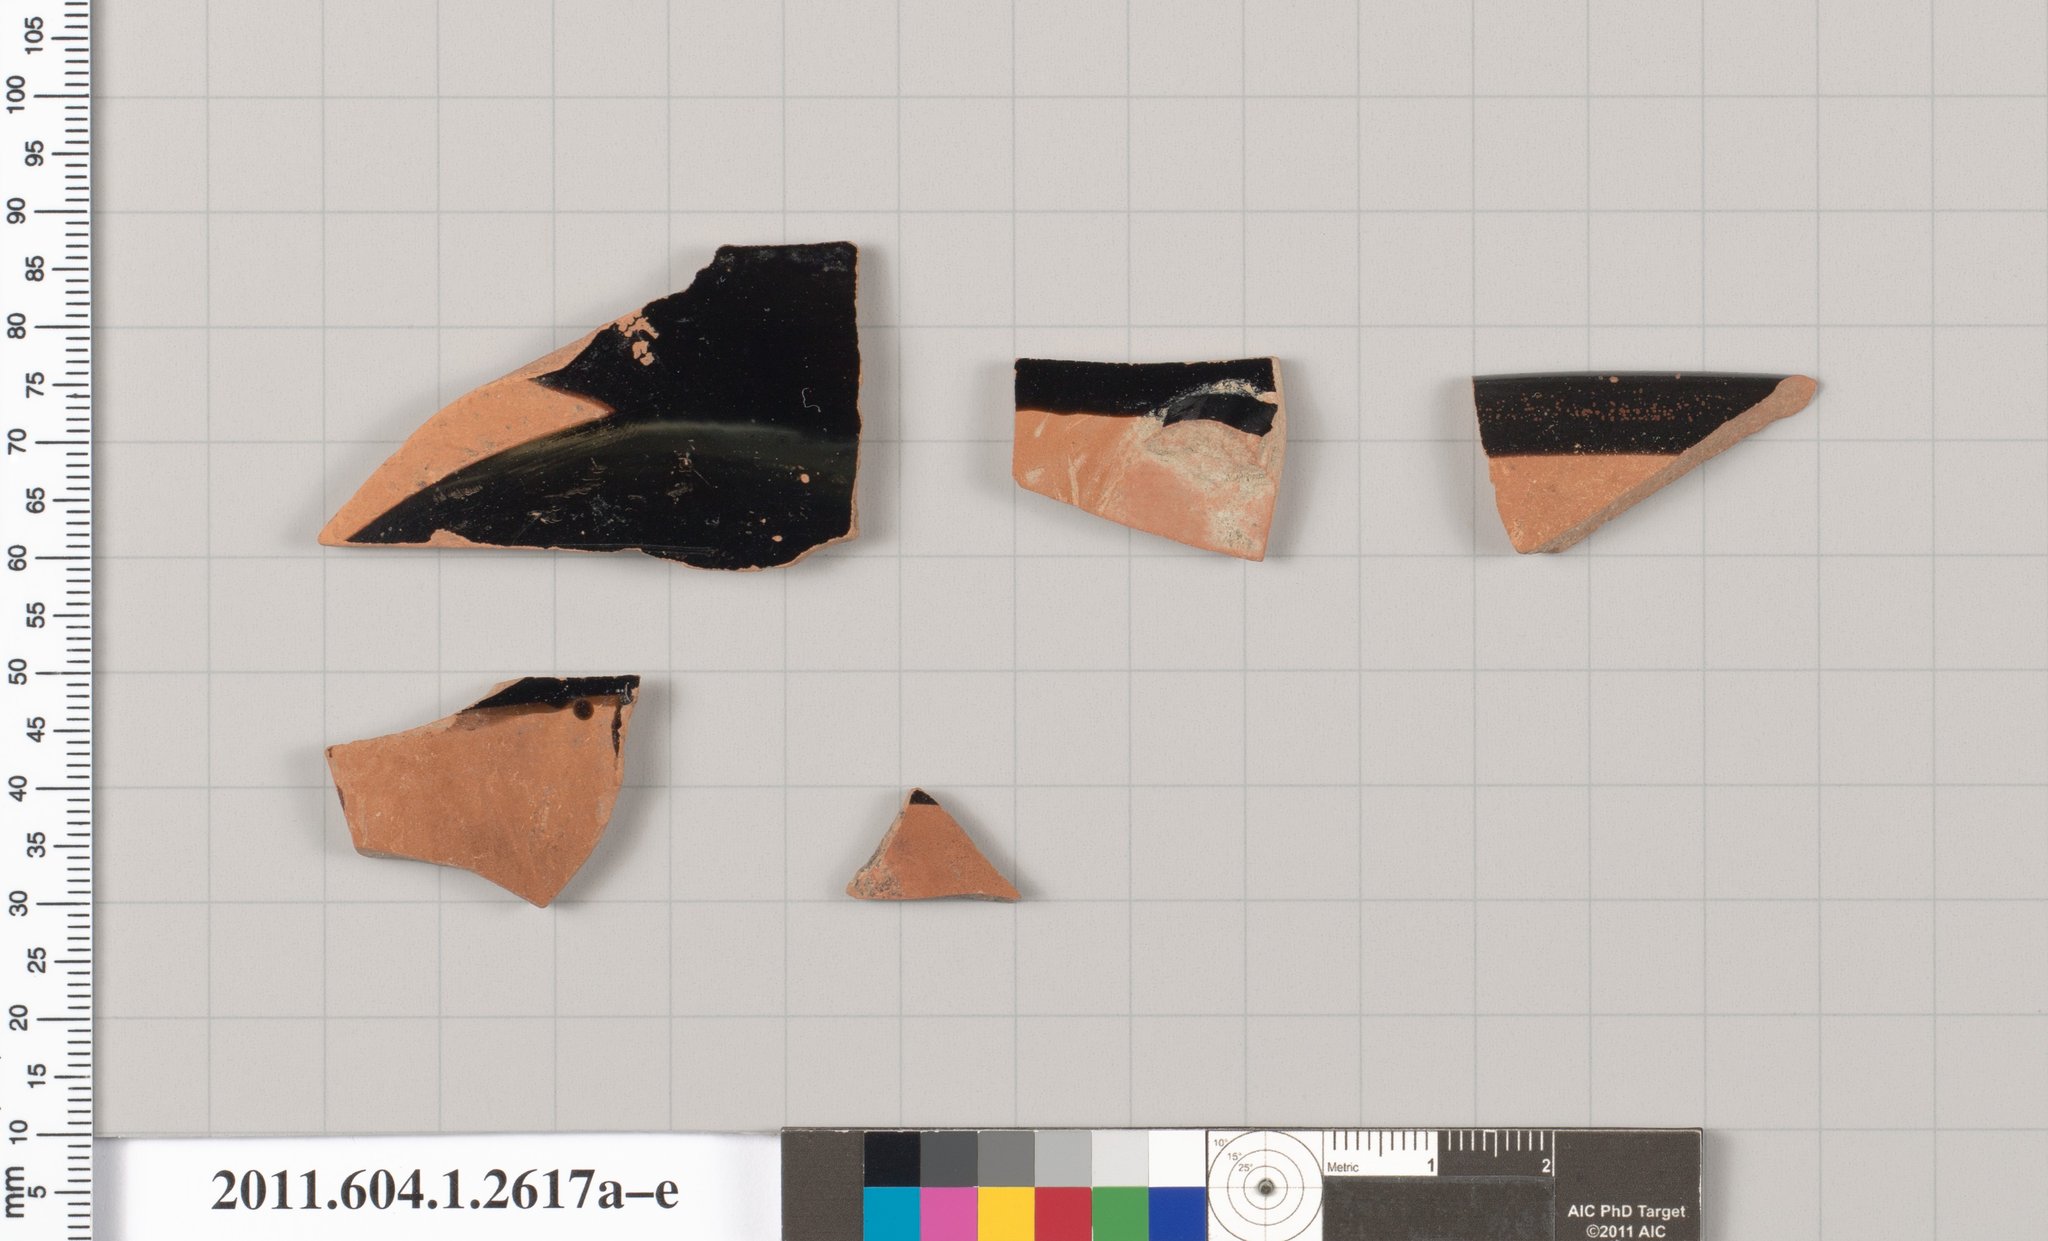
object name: kylix fragment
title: Terracotta fragments of kylikes (drinking cups)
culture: greek, attic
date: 500-401 BCE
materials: terracotta